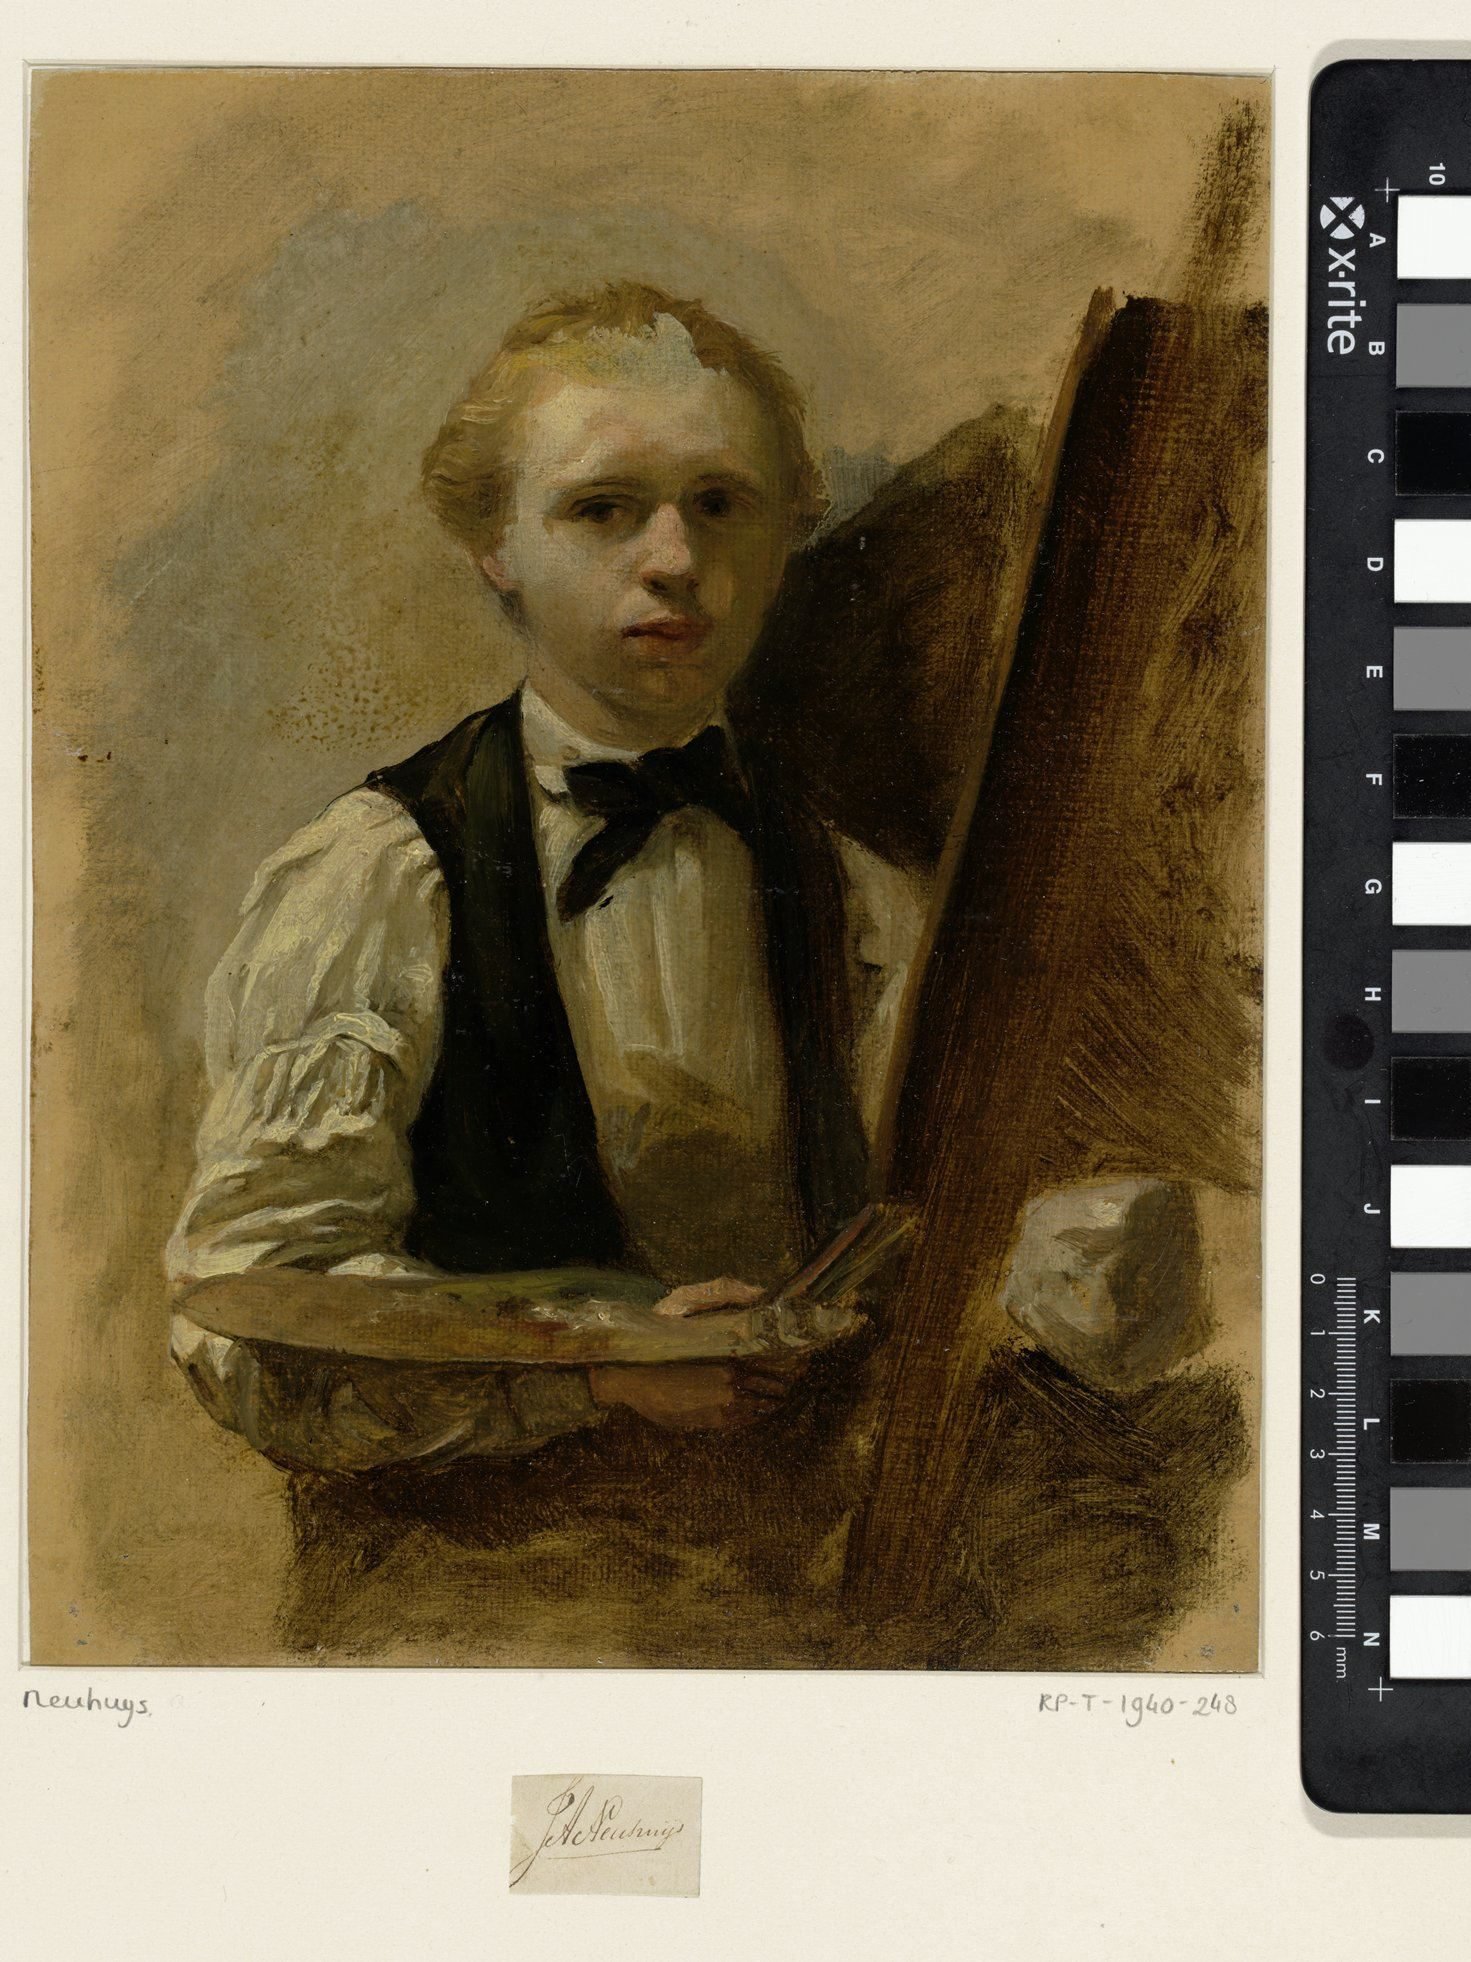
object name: painting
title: Zelfportret voor de ezel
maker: albert neuhuys (1844-1914)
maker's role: draughtsman, painter, print maker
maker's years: 1844-1914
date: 1854-1914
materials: linen, oil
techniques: brush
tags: utrecht, painter, print maker, draughtsman, albert neuhuys (1844-1914), historical persons, portrait, self-portrait of artist